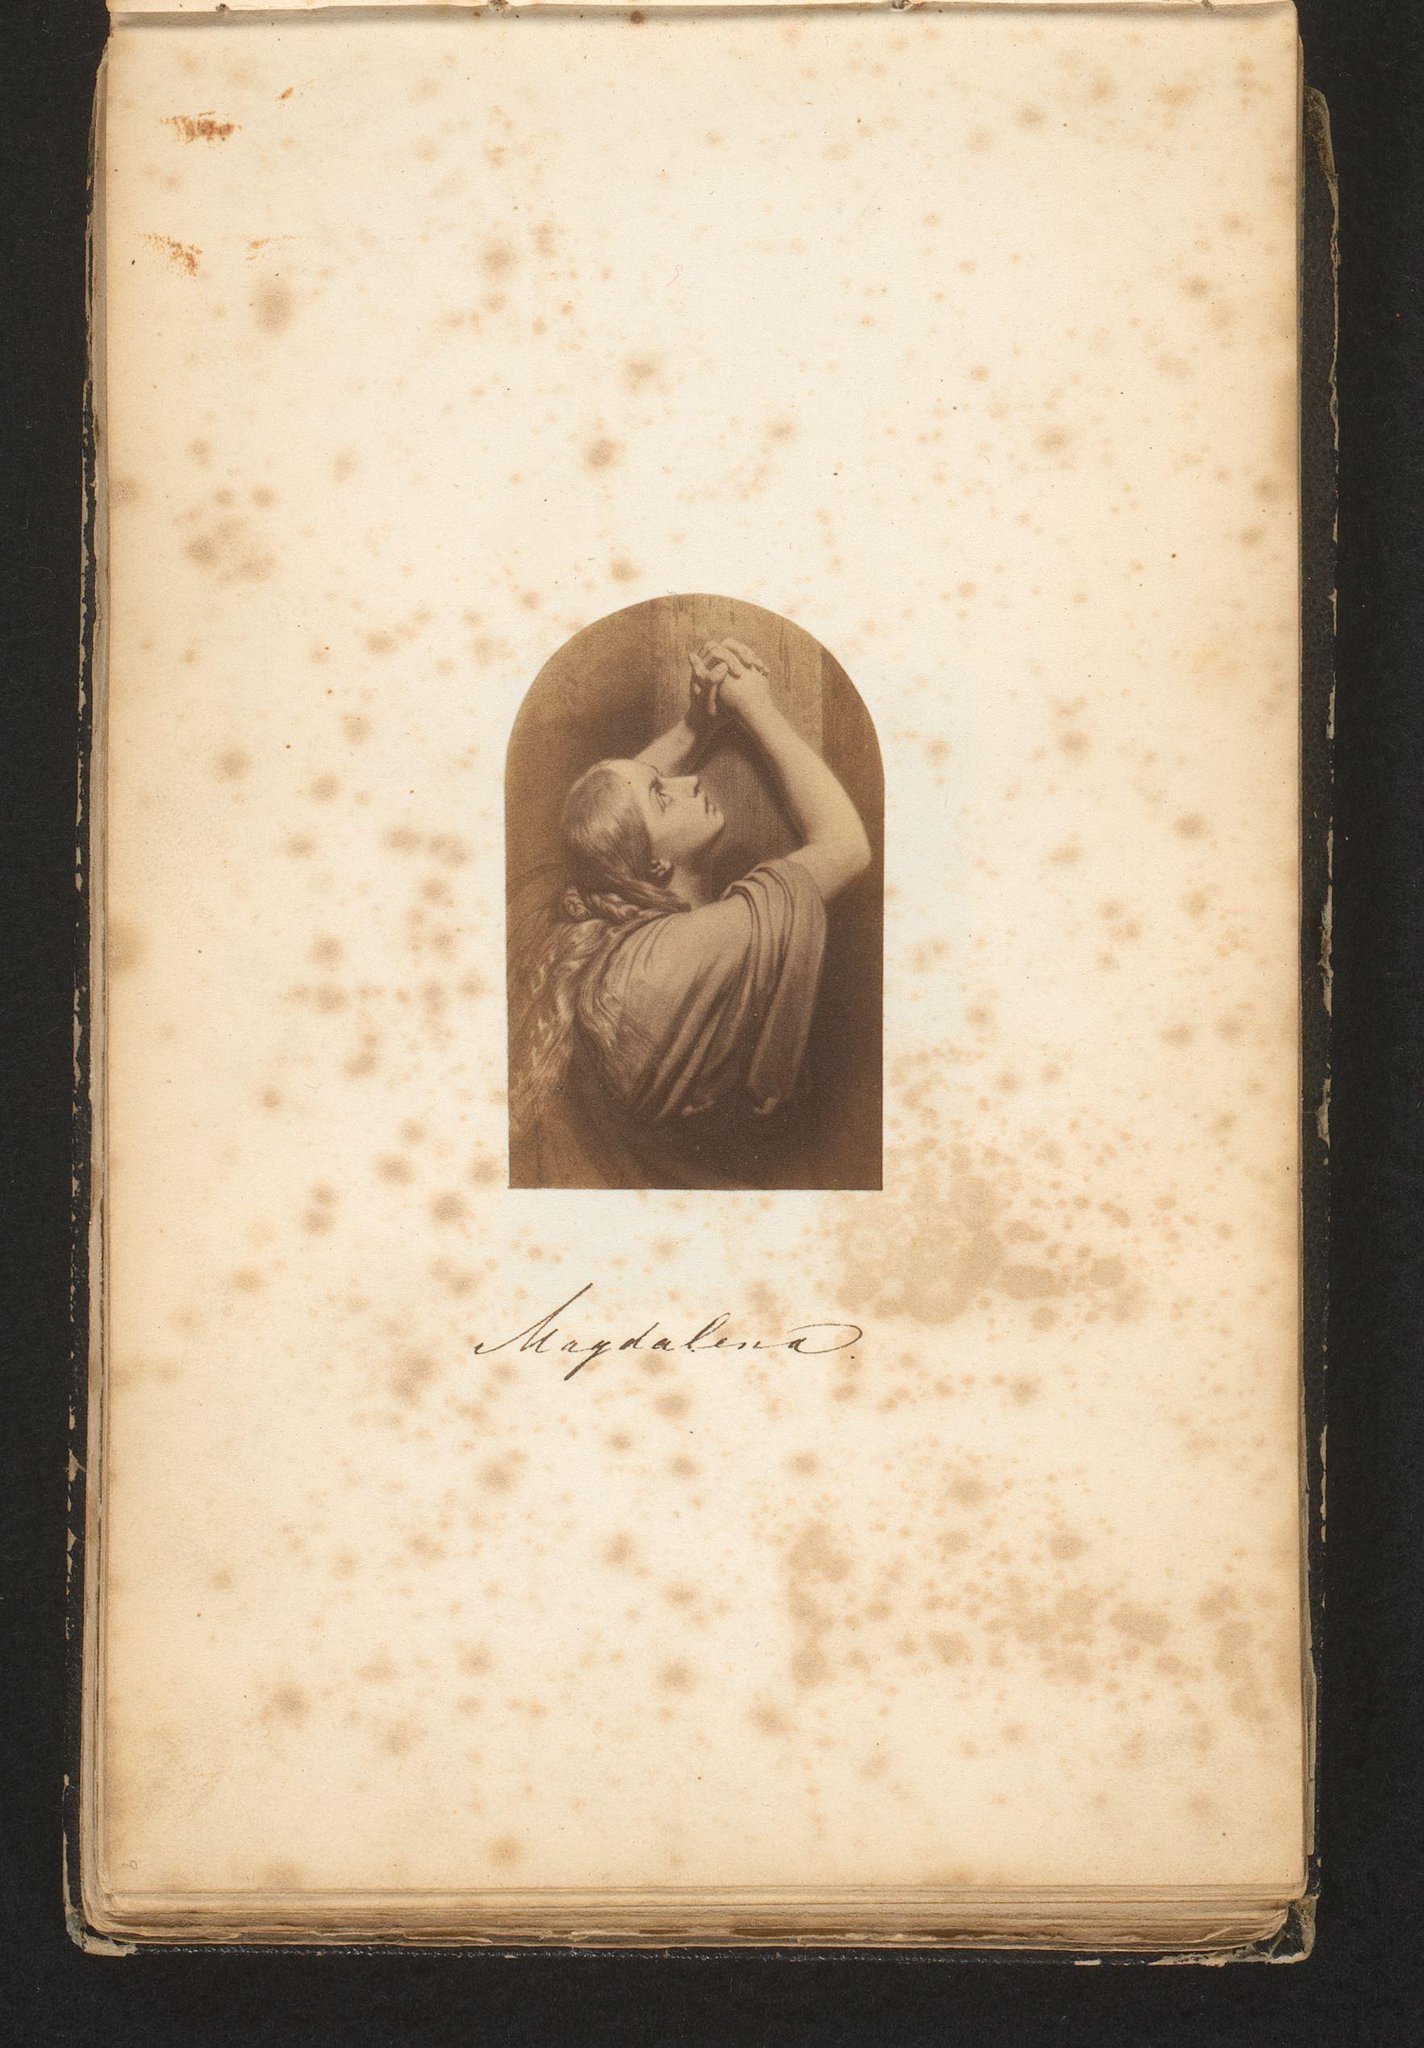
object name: photograph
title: Fotoreproductie van een schilderij van Magdalena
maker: Anonymous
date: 1860-1900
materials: photographic support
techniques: albumen print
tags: female saints (with name), painting, drawing and the graphic arts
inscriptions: annotation: ‘Magdalena’